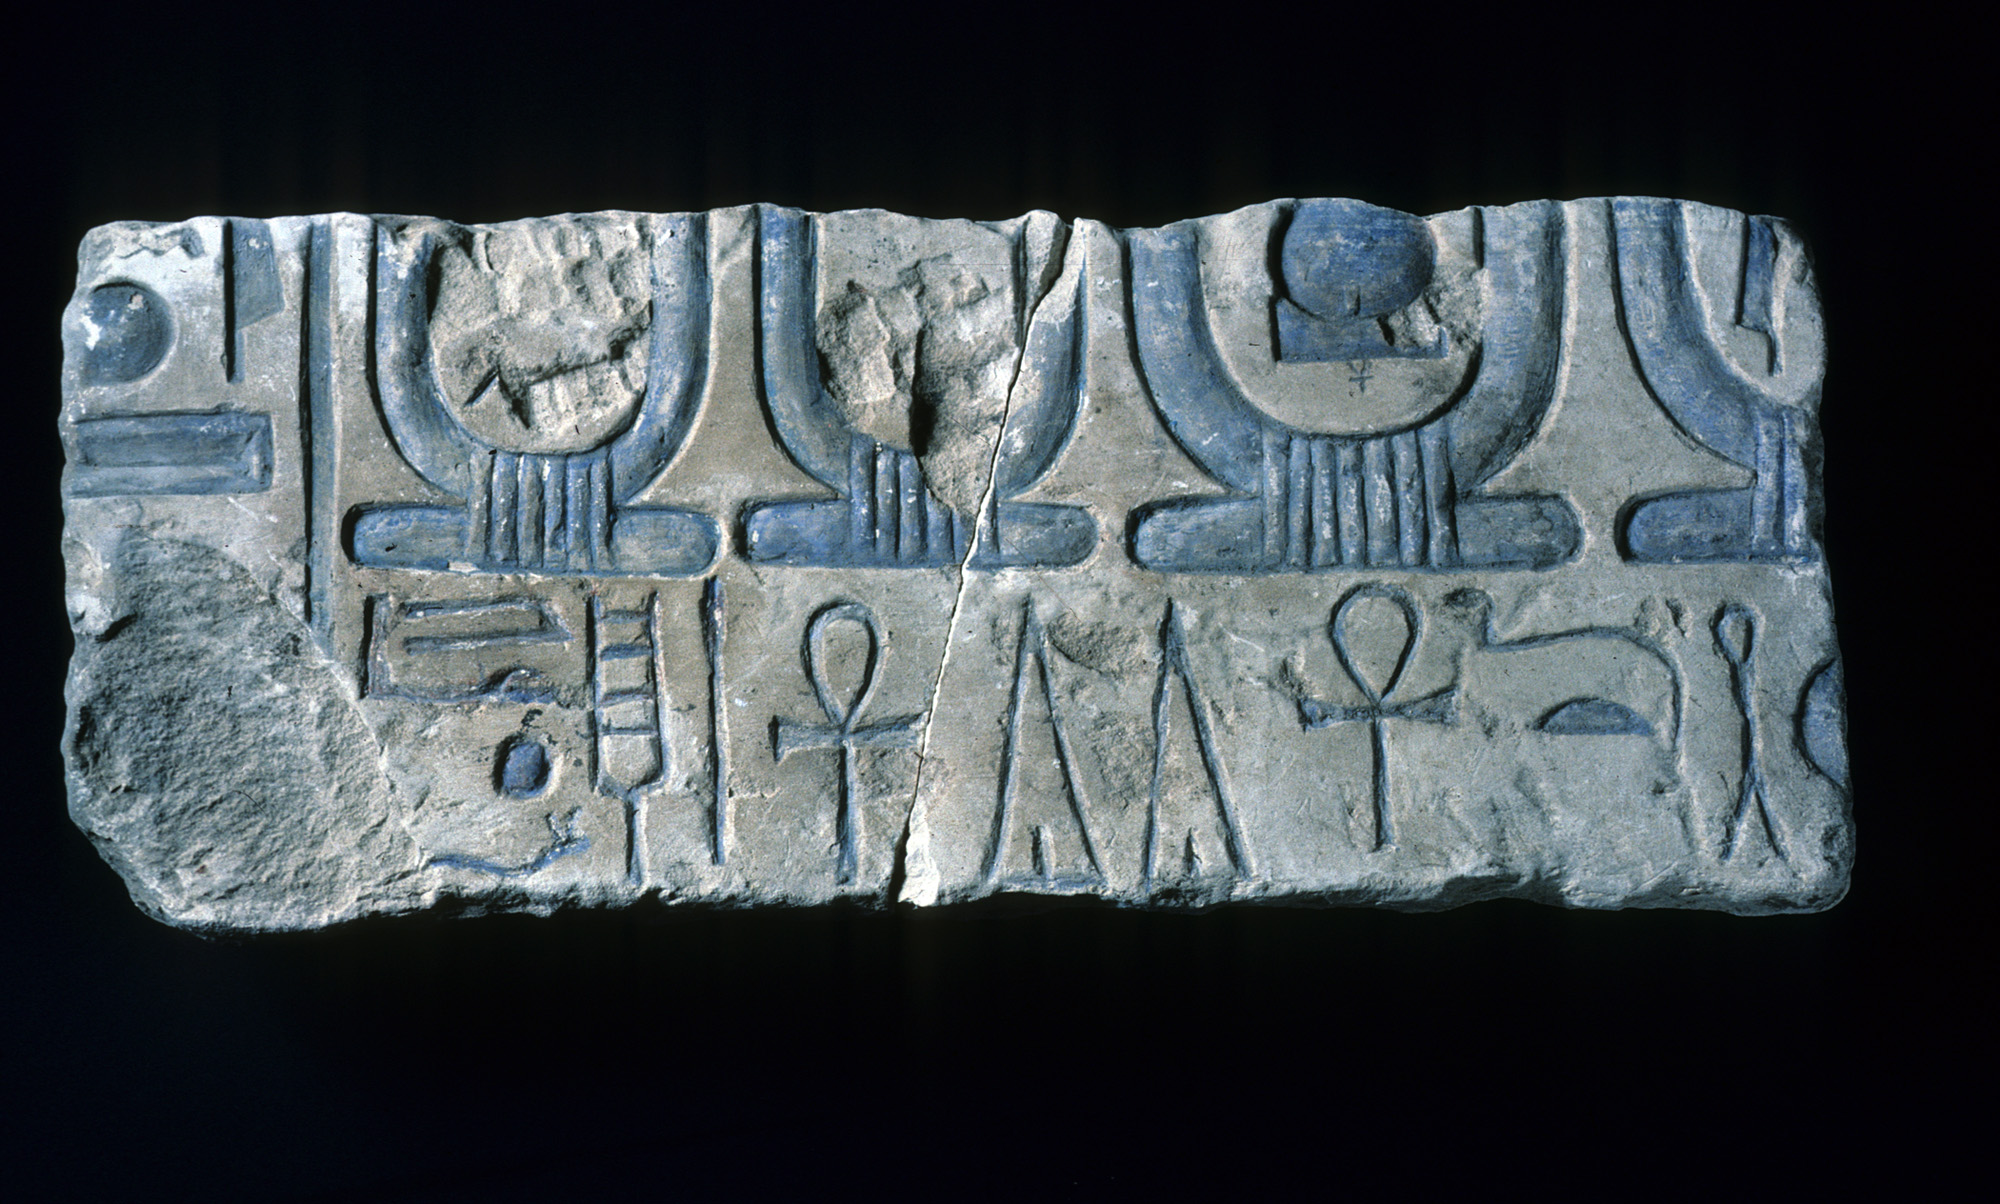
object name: talatat, cartouch of aten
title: Relief with cartouches of Aten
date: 1353-1336 BCE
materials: limestone, paint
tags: hieroglyphs